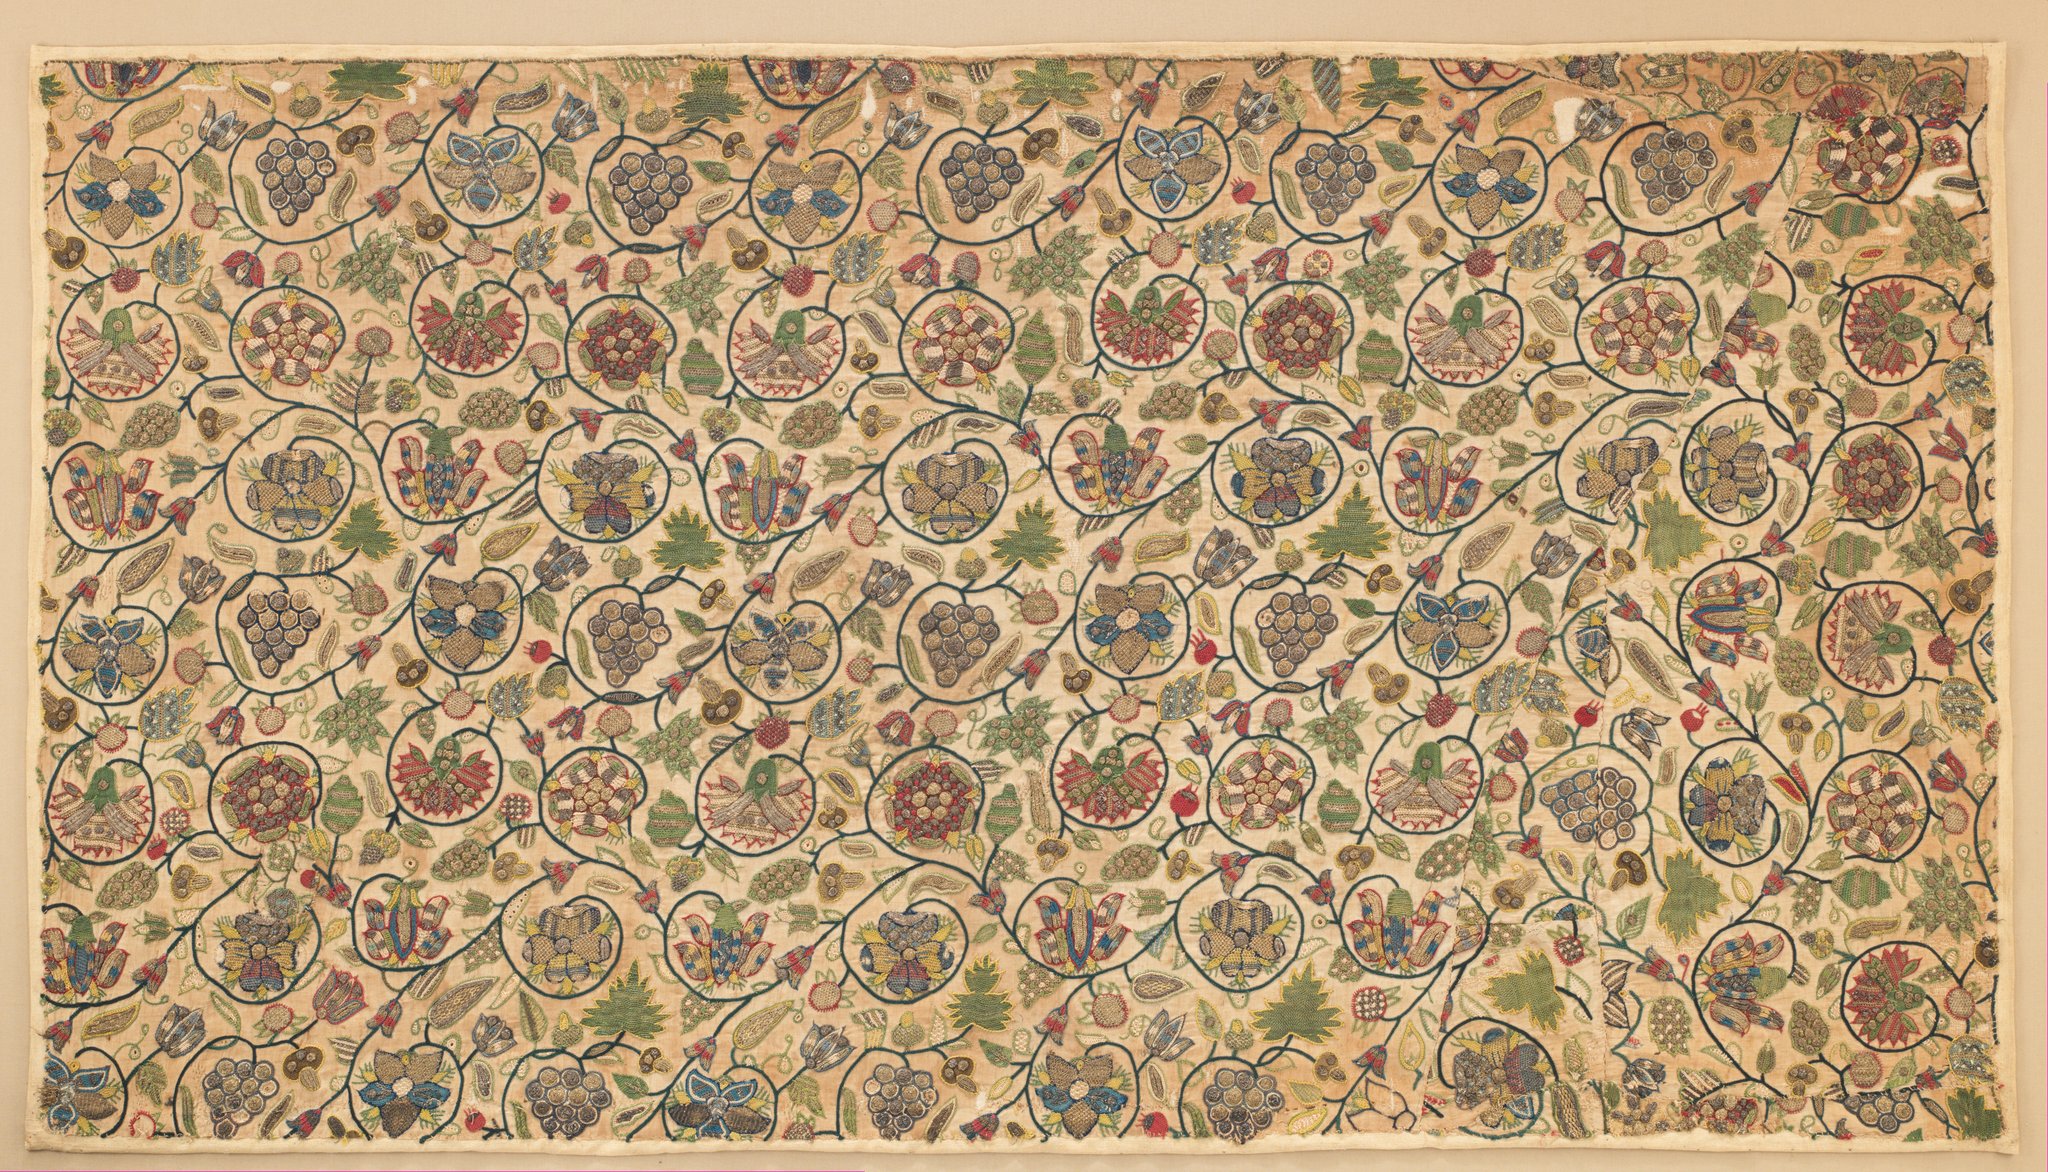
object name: cushion cover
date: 1600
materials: linen, silk, thread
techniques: embroidery, gilding, stitching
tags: flowers